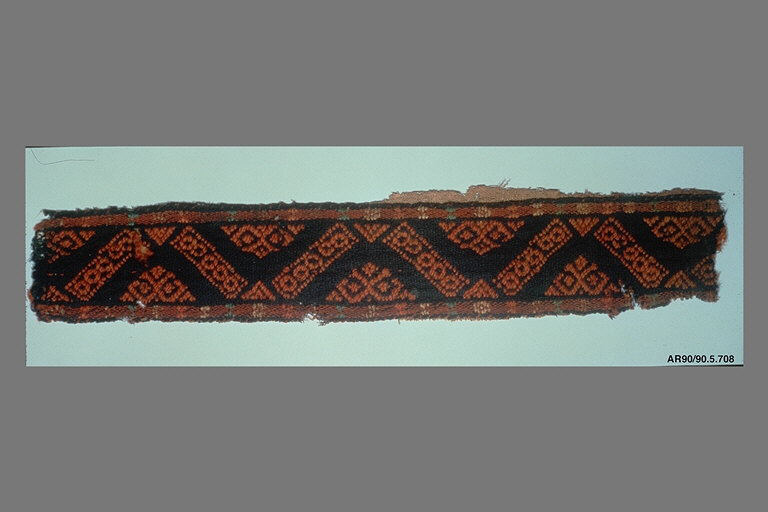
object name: textile fragment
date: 401-600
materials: wool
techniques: brocade, weave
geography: egypt